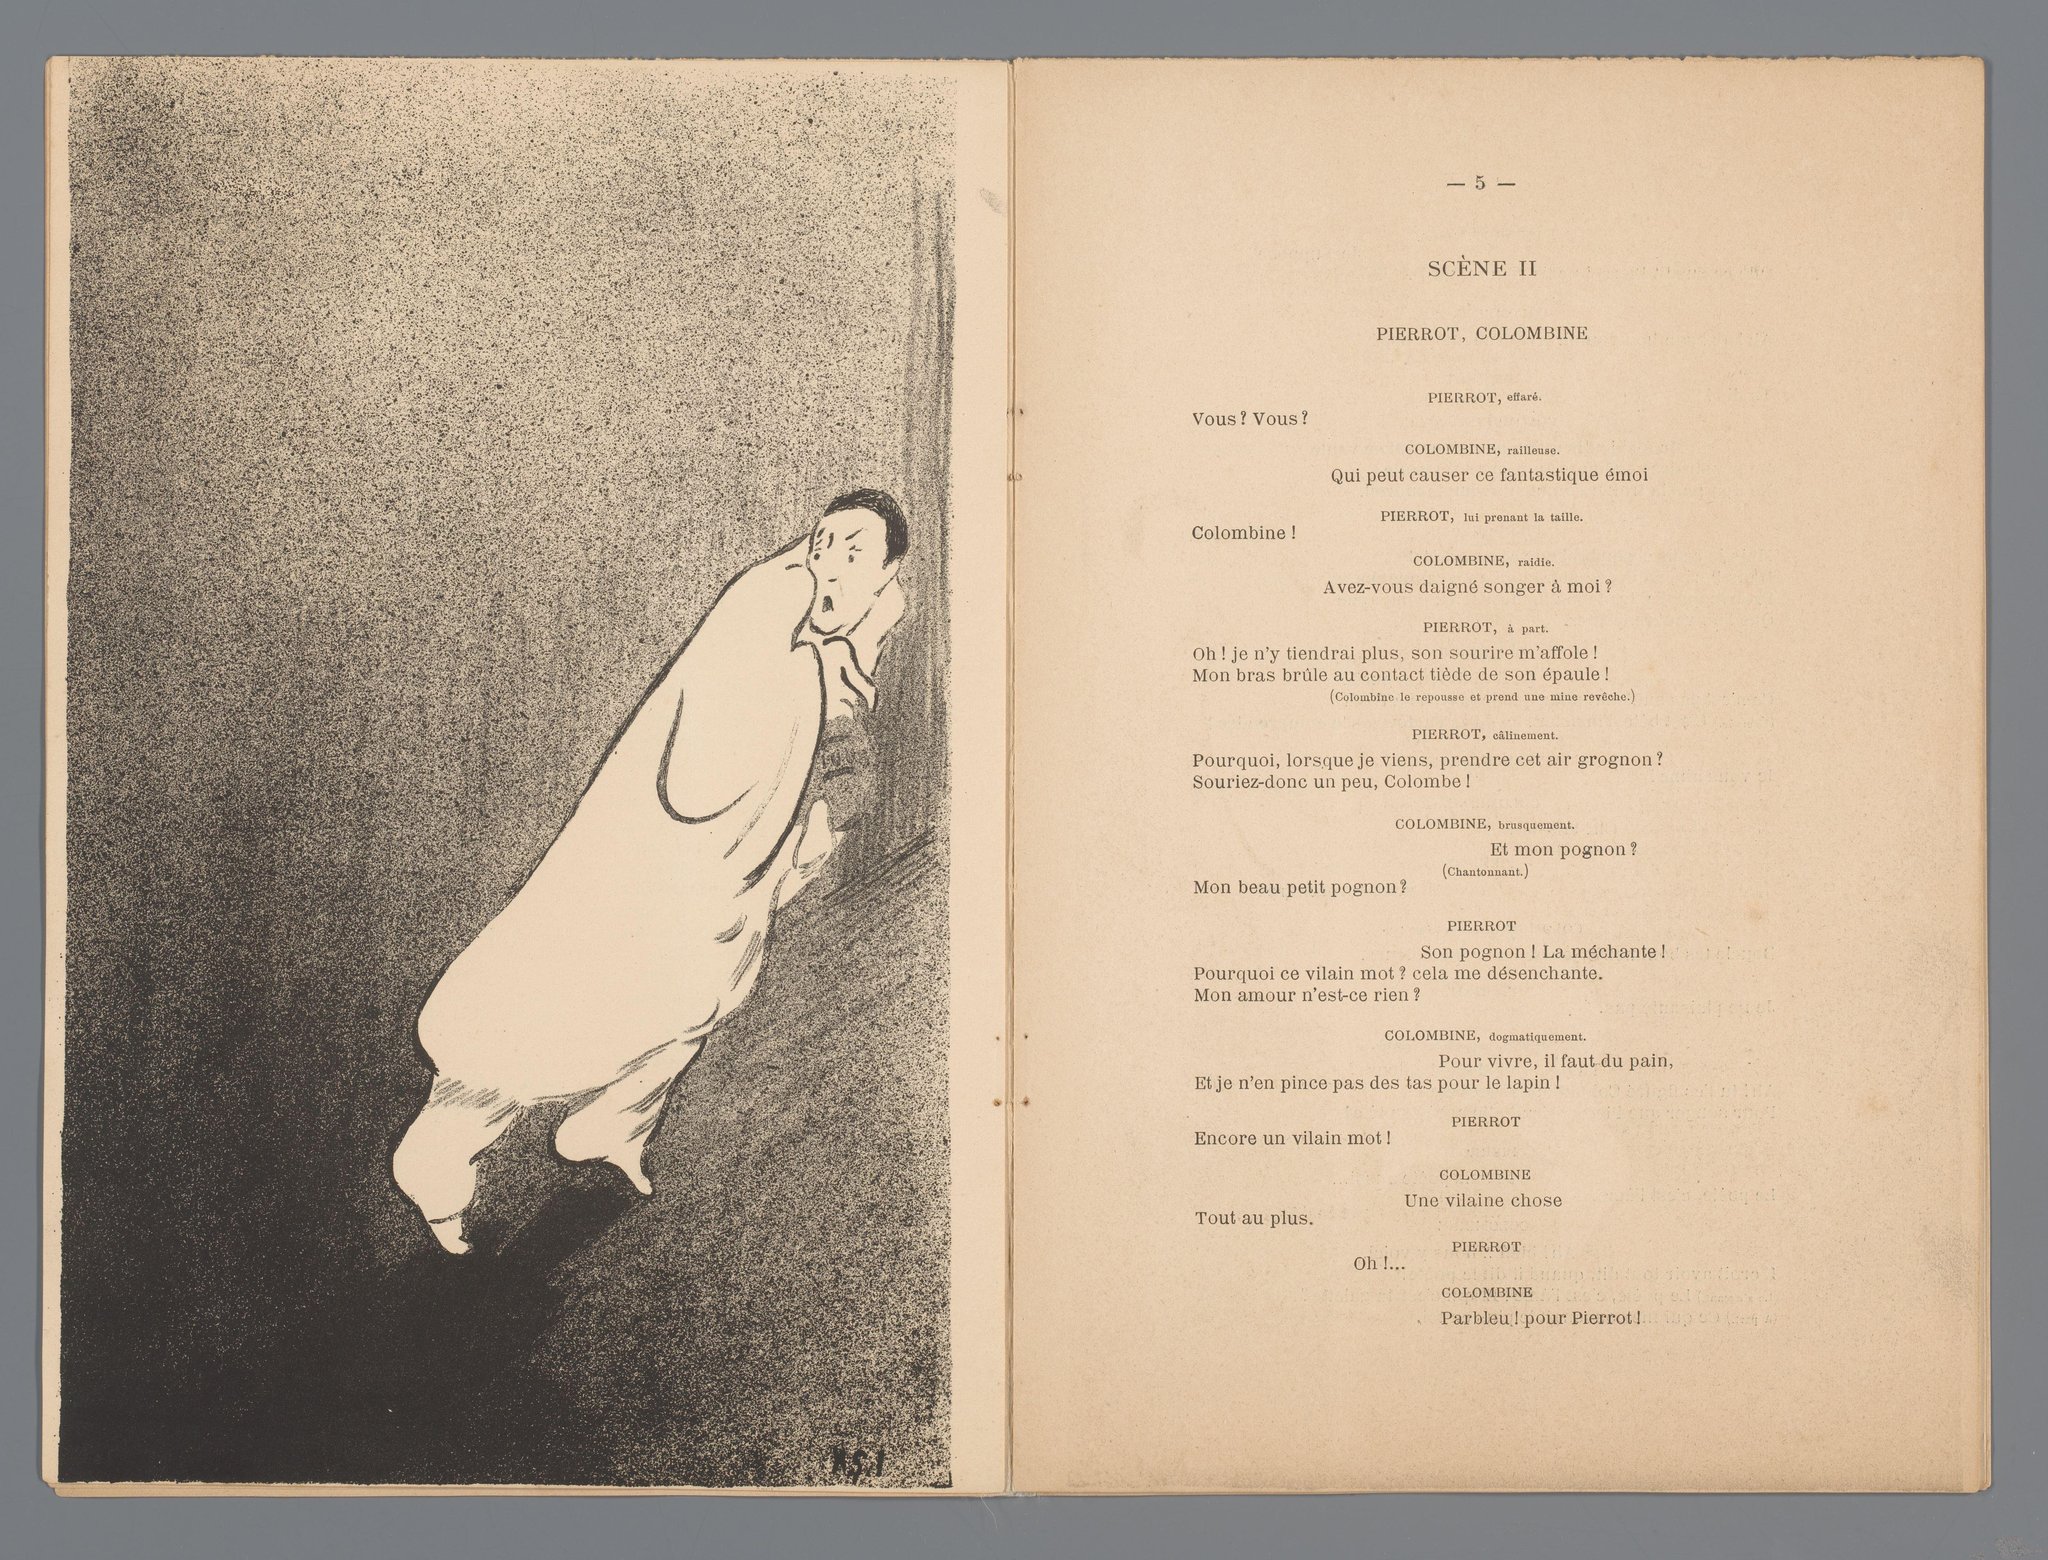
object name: print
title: Liefdesdans tussen een man en een ballerina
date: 1892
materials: paper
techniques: lithograph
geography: paris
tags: standing figure, shadow, relations between the sexes